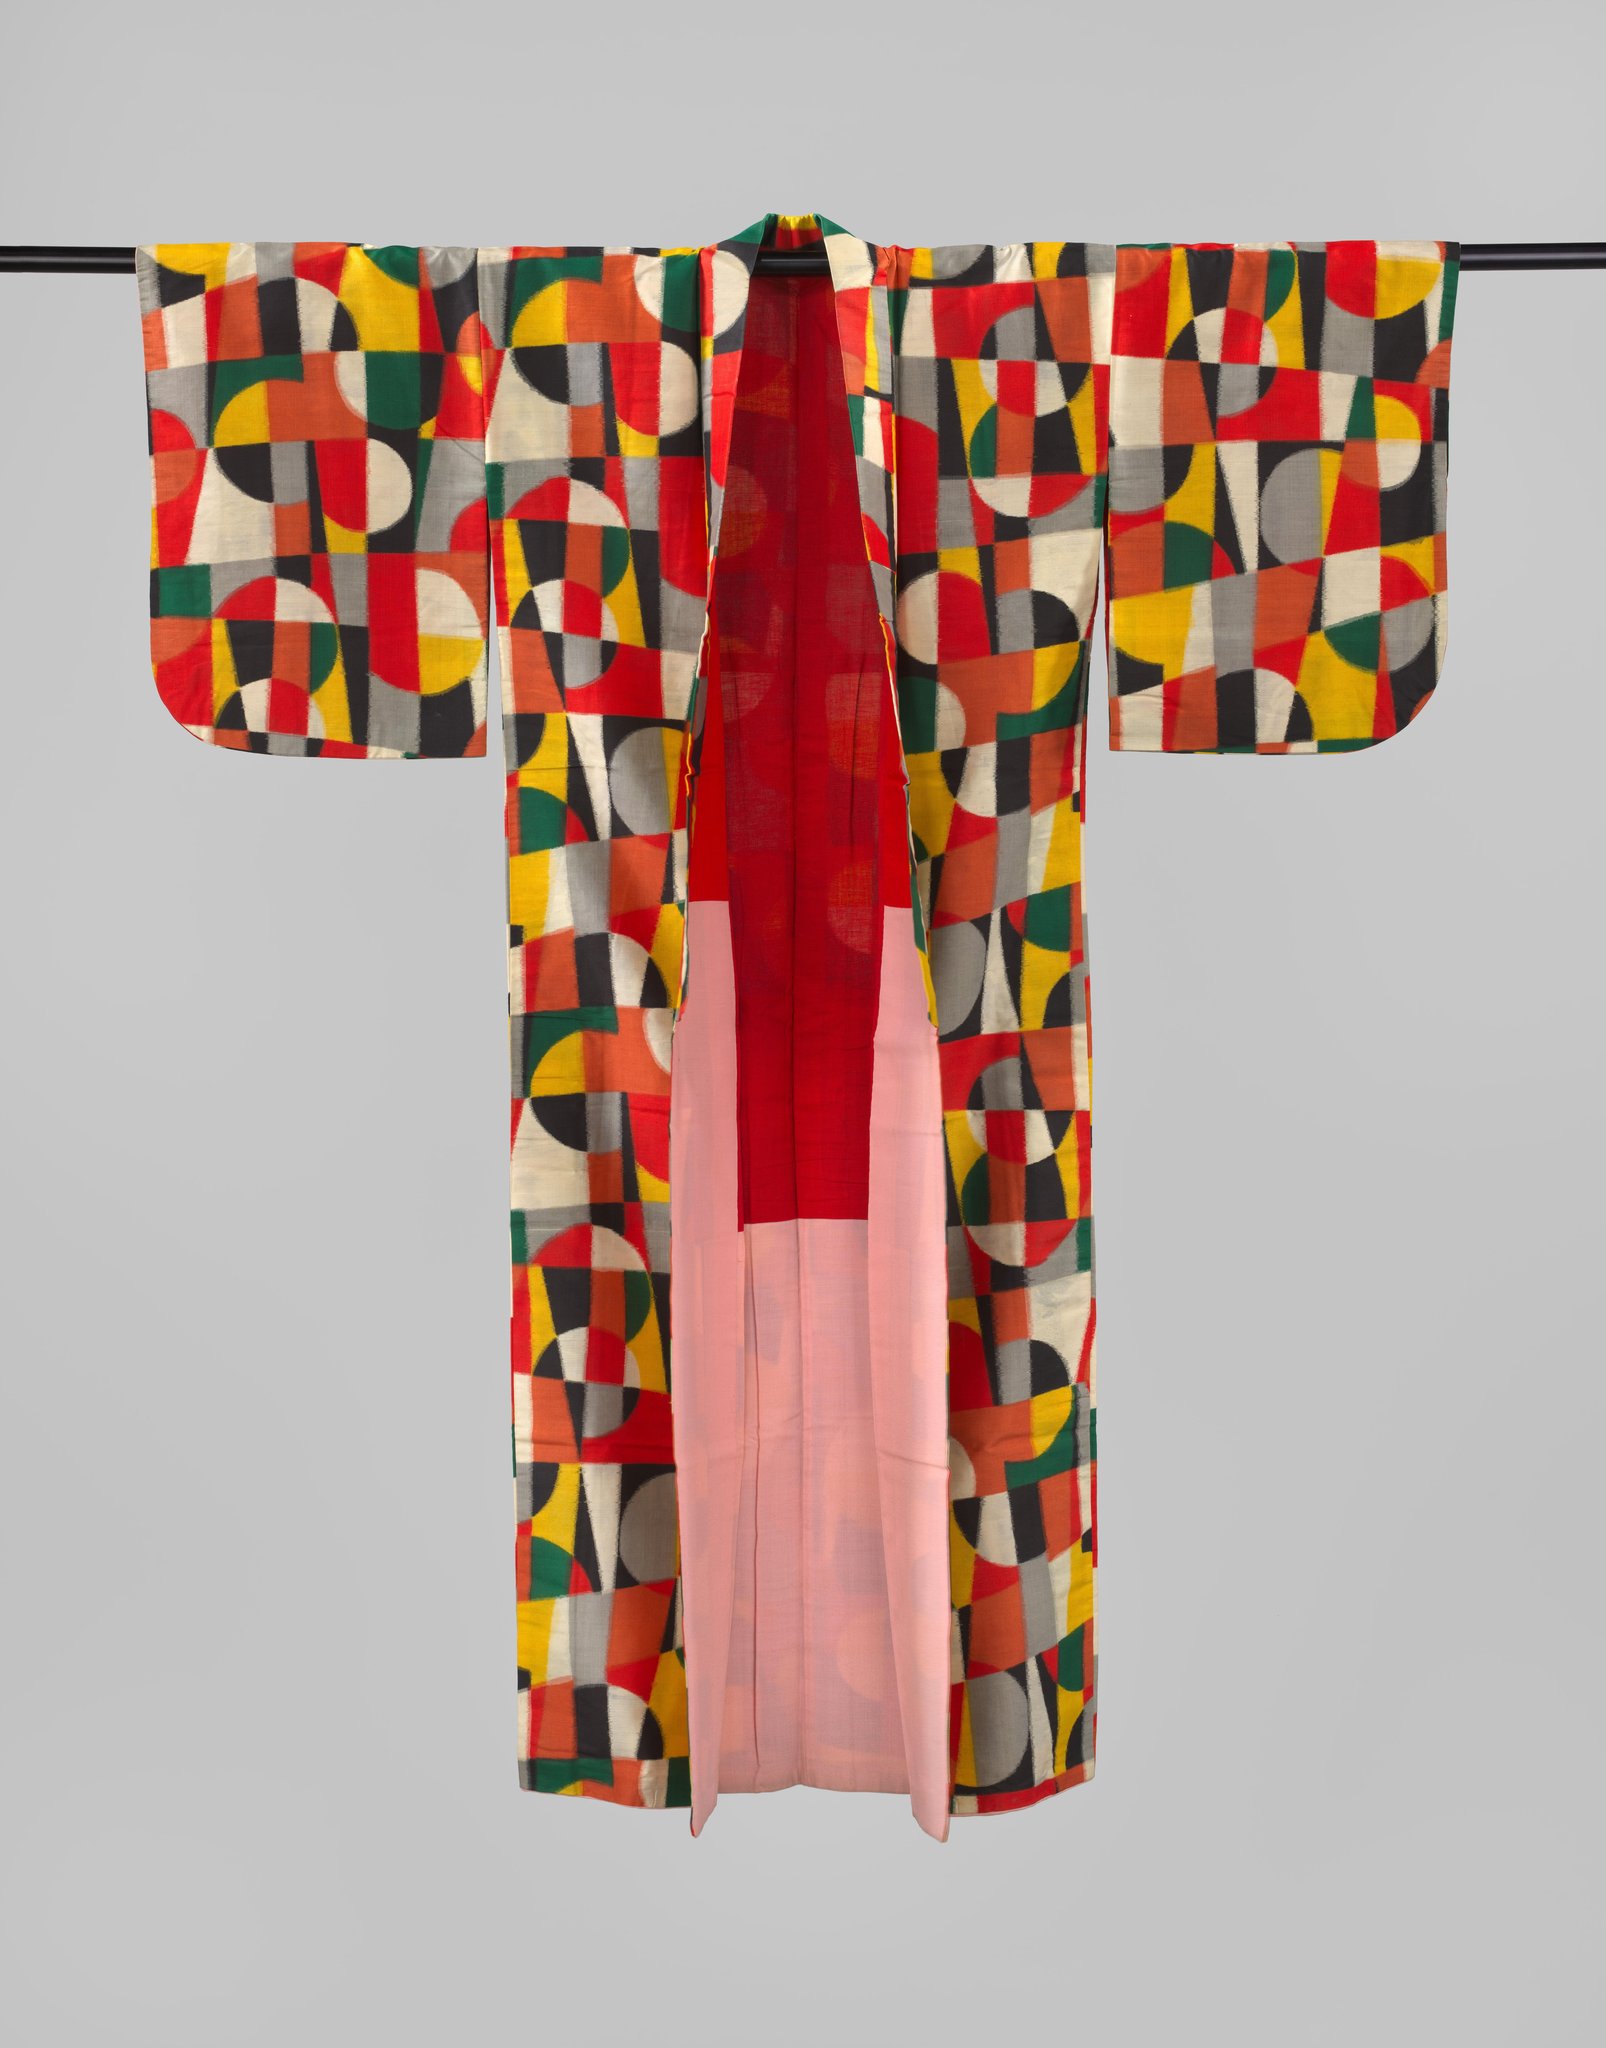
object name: kimono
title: Dagelijkse informele dameskimono met gekleurd geometrisch dessin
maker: Anonymous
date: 1930-1940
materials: silk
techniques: printing, weave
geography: japan